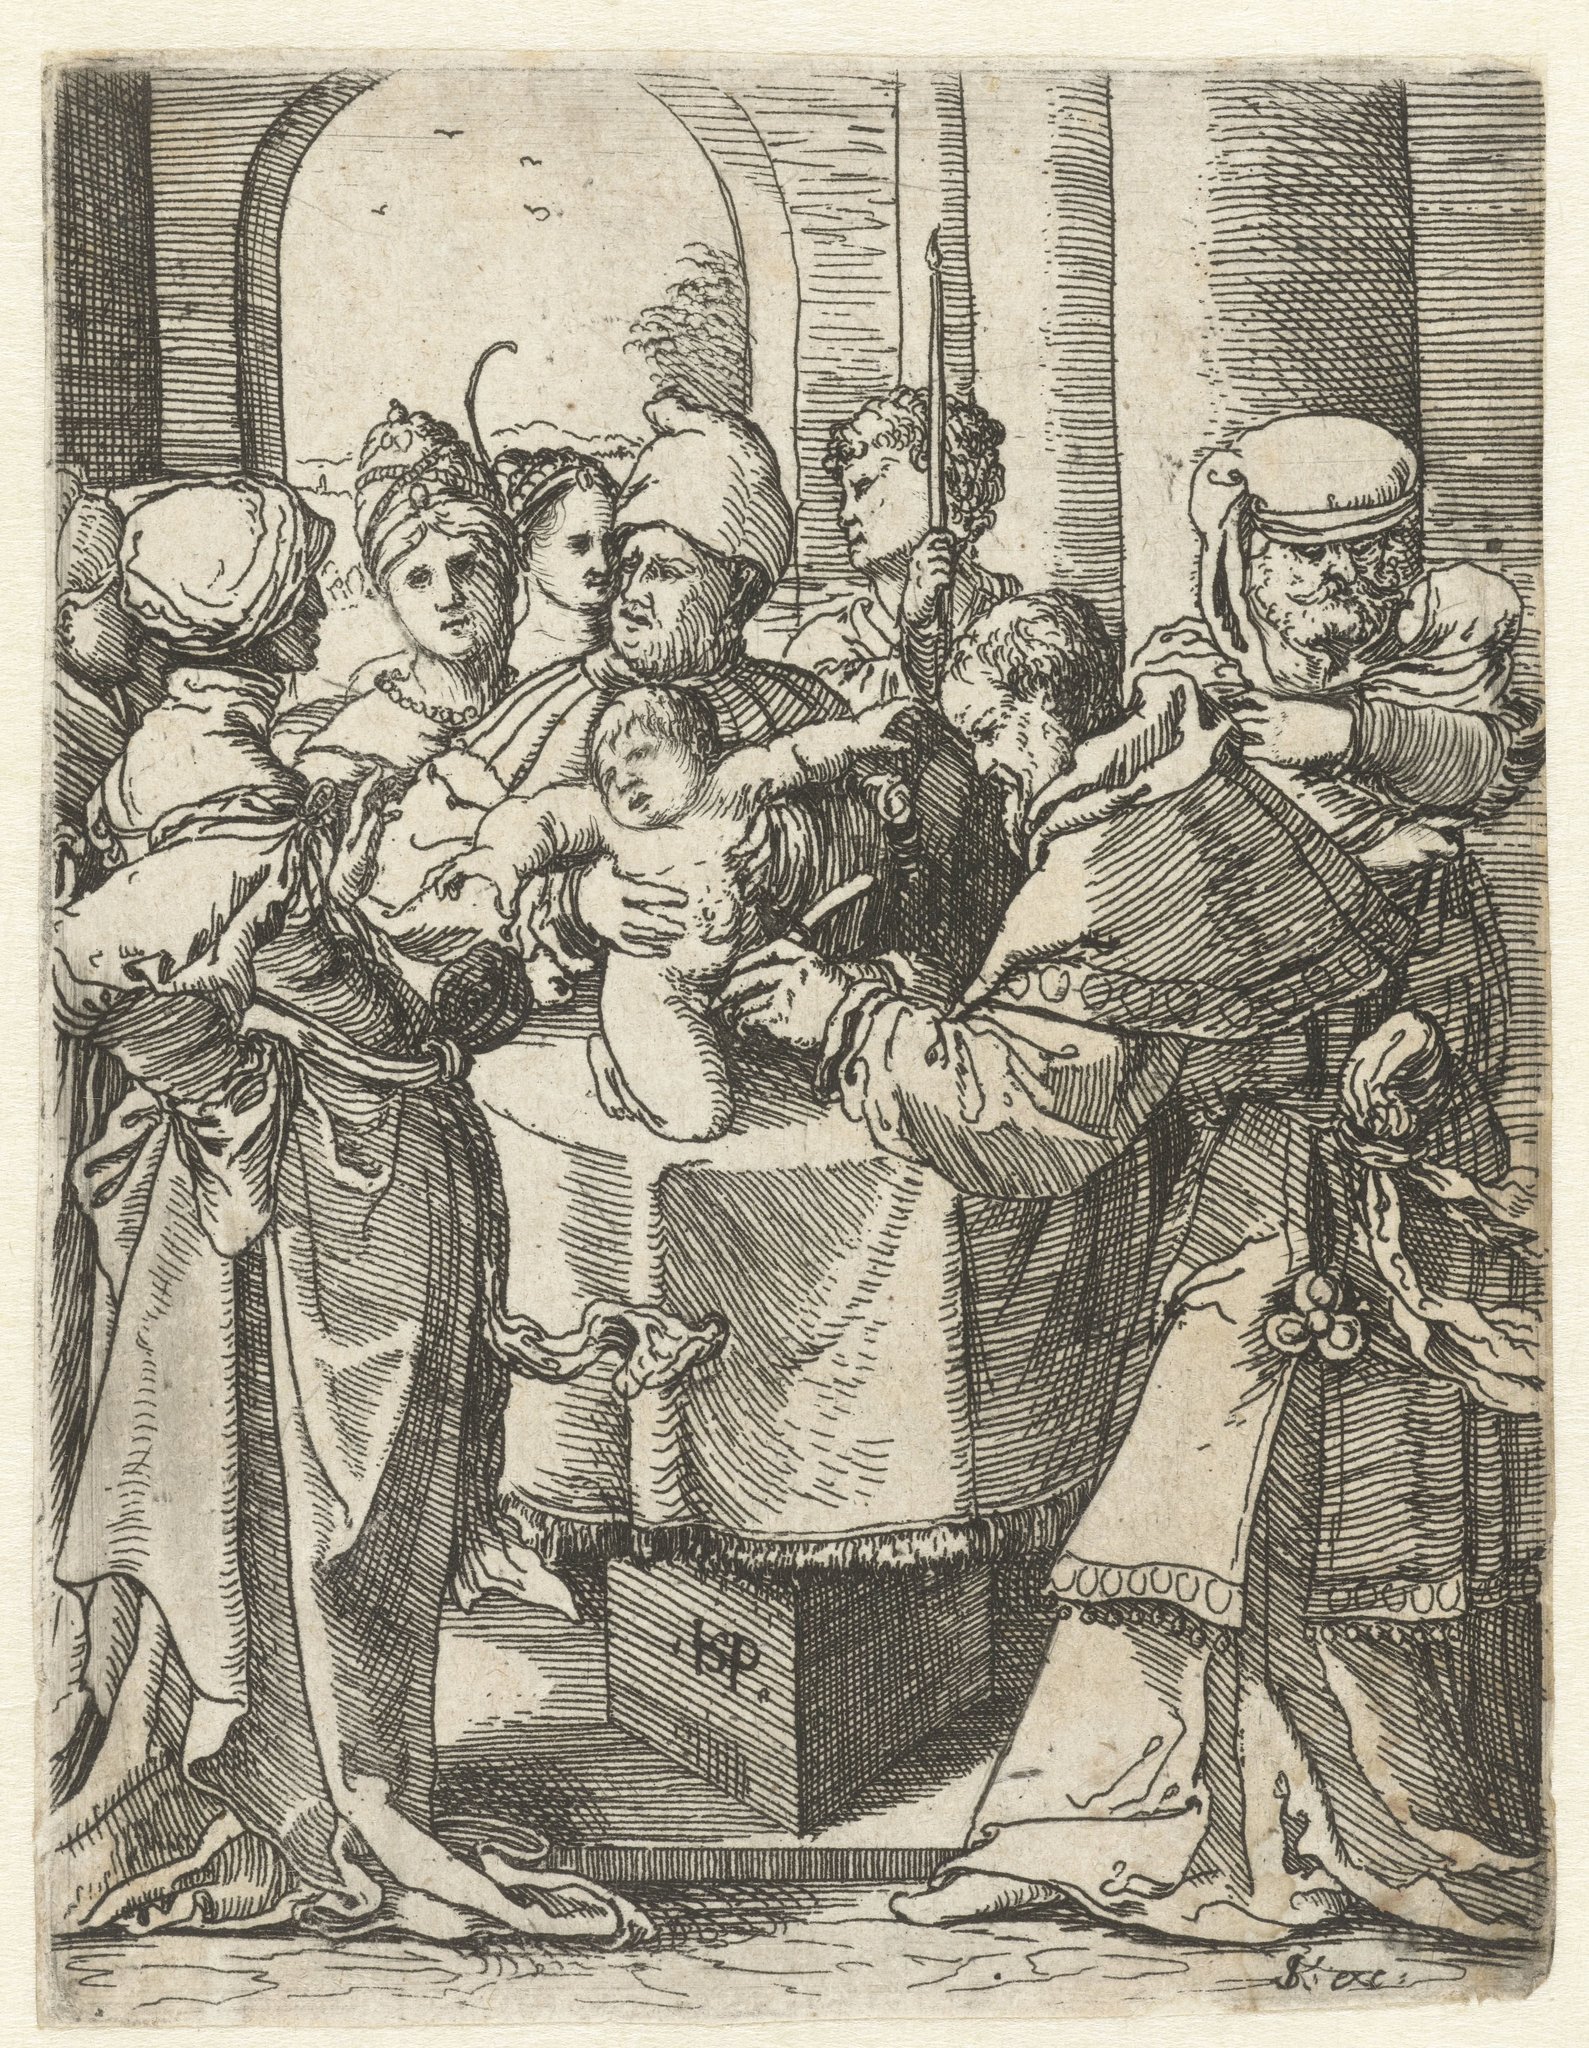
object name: print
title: Besnijdenis van Christus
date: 1510-1550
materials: paper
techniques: etching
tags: circumcision of the christ-child by the priest in the temple (luke 2:21)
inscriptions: collector's mark: Lugt 240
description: Kopie naar houtsnede van Jan Swart van Groningen